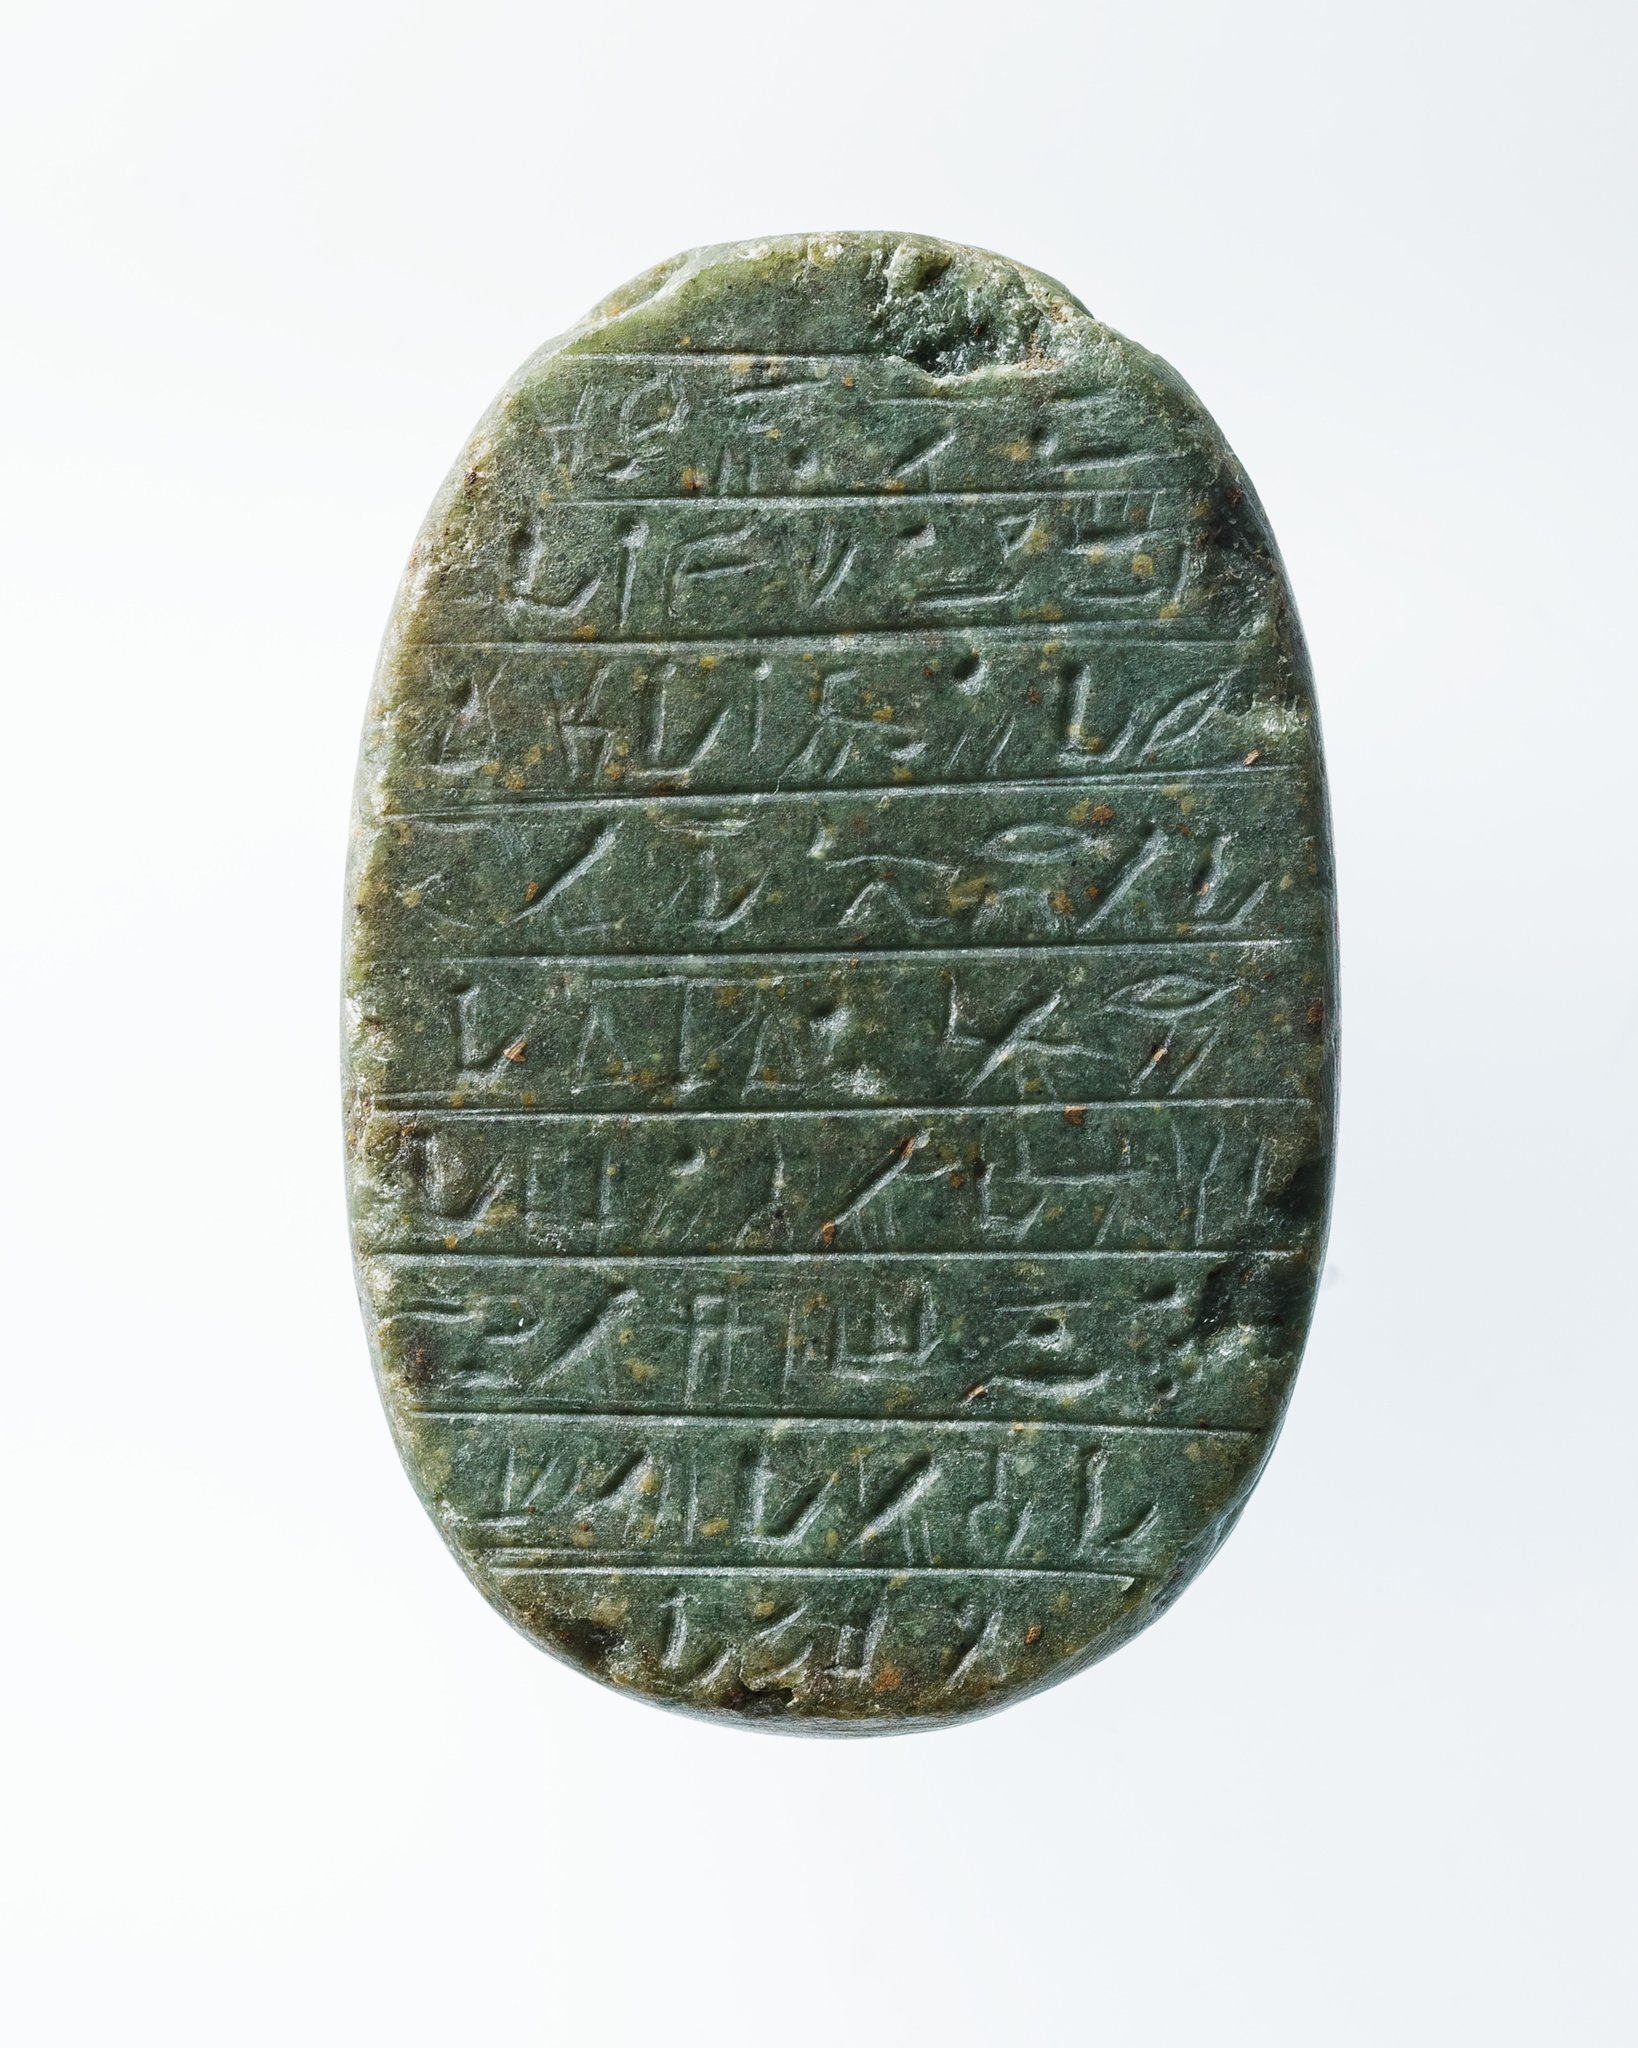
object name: heart scarab, henettawy c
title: Heart Scarab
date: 990-970 BCE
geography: egypt